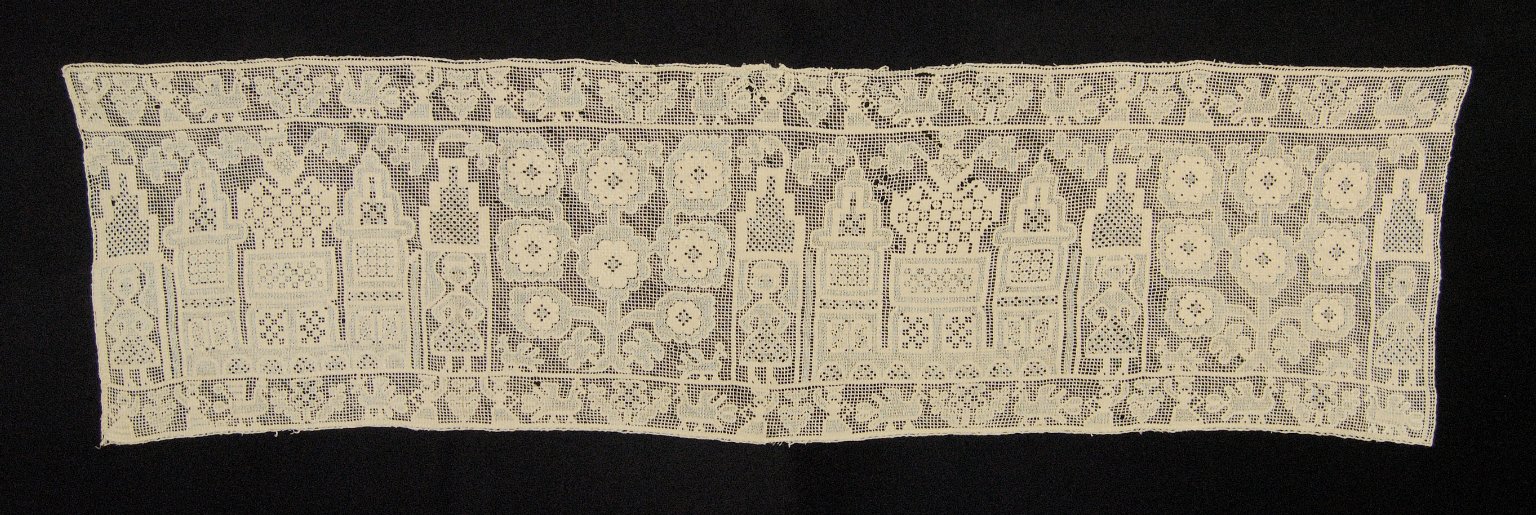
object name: border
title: Bed curtain border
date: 1800-1850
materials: linen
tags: human figures,birds